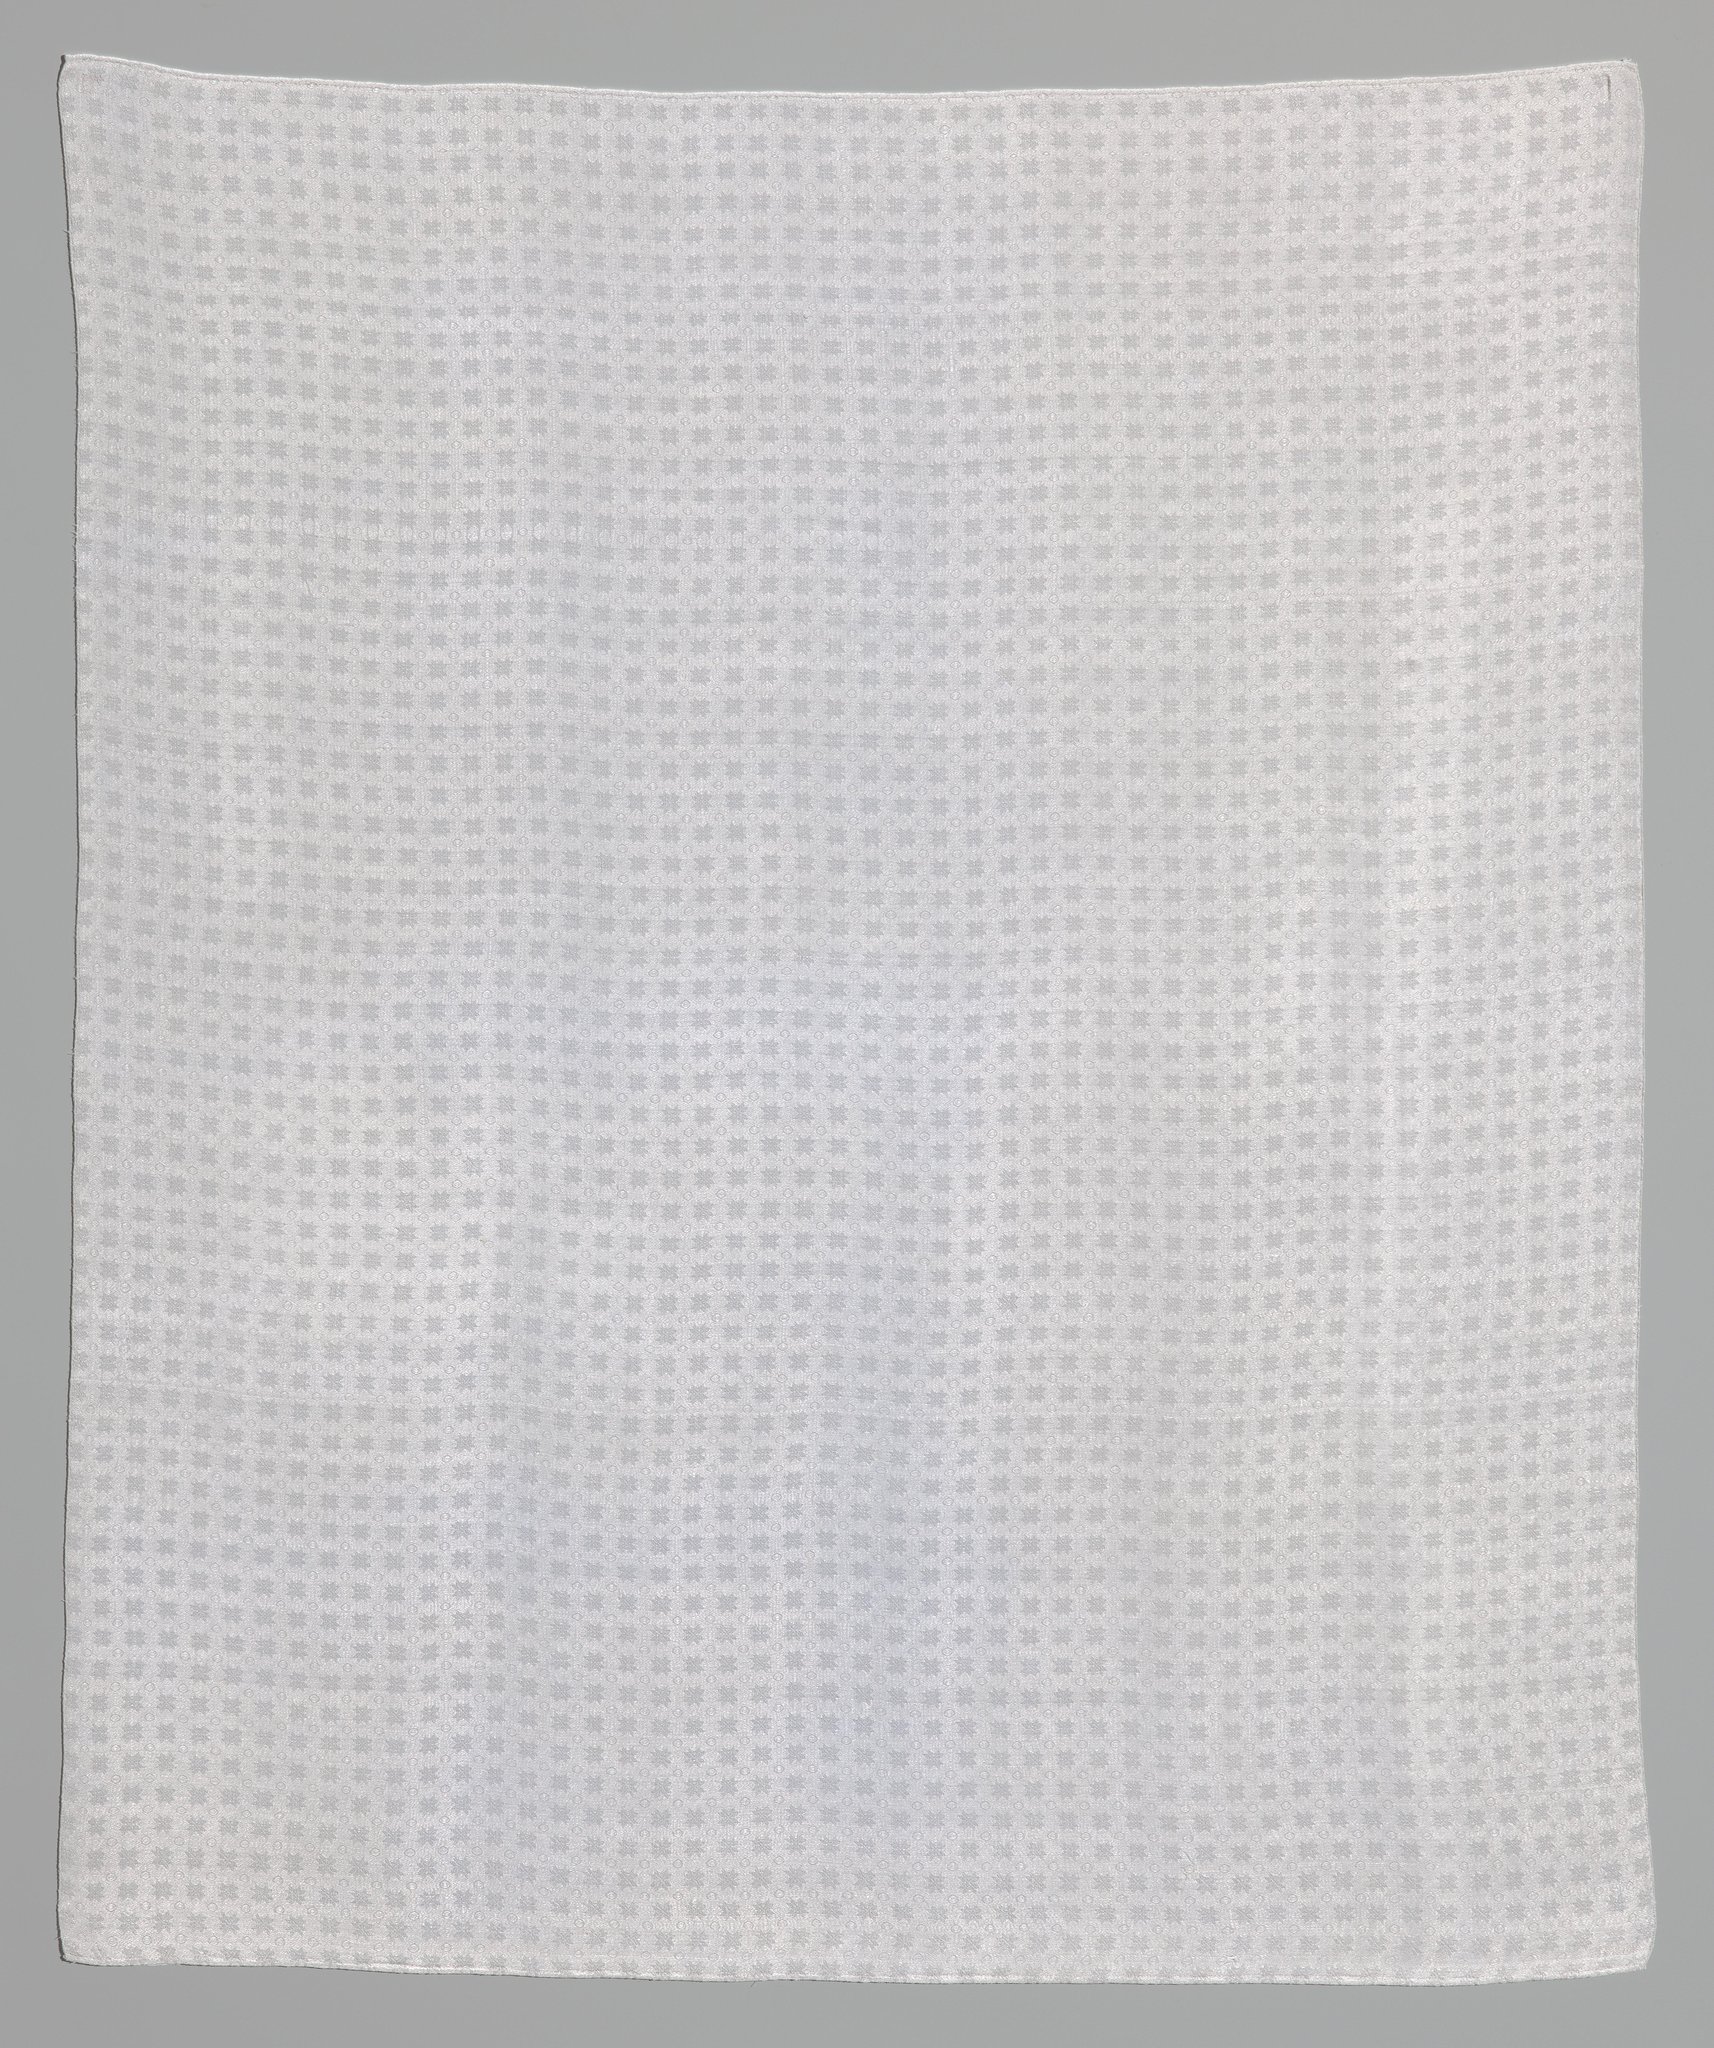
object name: towel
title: Handdoek van wit linnen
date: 1800-1875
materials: linen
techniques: damask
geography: northern netherlands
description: Wit linnendamasten handdoek met een patroon met een ster en rondje, merk RVD HW 36.